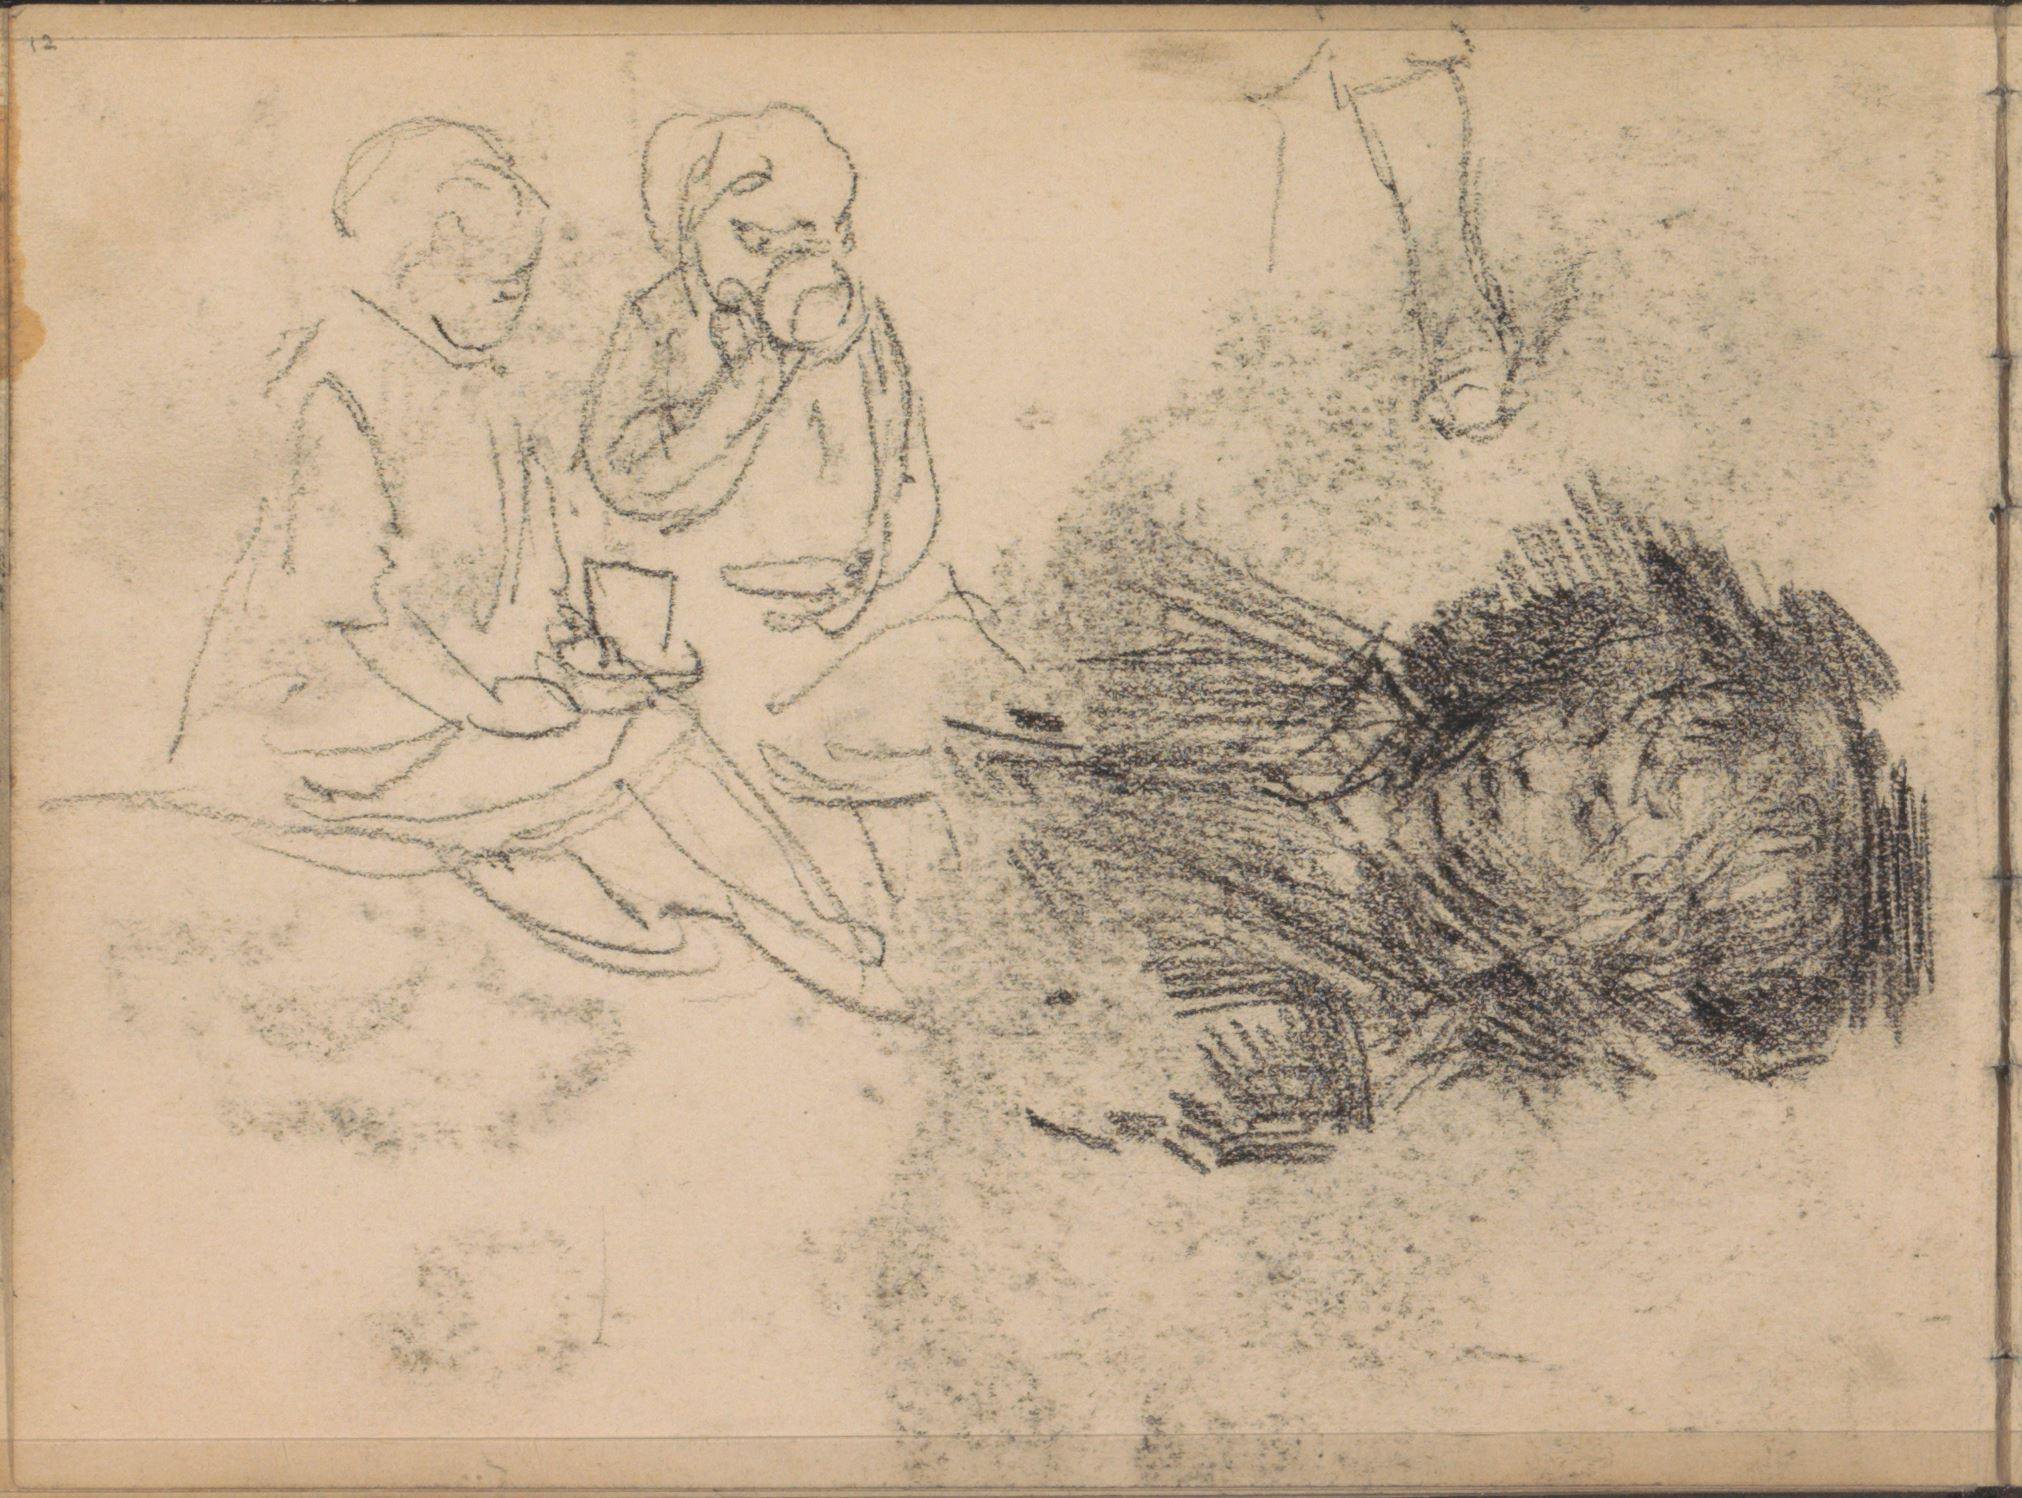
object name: sketchbook leaf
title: Studieblad, met onder andere een jongenskop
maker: marius bauer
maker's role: draughtsman, print maker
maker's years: 1867-1932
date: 1879-1884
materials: chalk, paper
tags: head (human), lower leg, sitting figure, boy (child between toddler and youth), girl (child between toddler and youth), drinking, cup and saucer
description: Tevens een studie van twee zittende meisjes, waarvan één drinkt uit een kop met schotel en een studie van een onderbeen. Pagina 12 uit een schetsboek met 28 bladen.